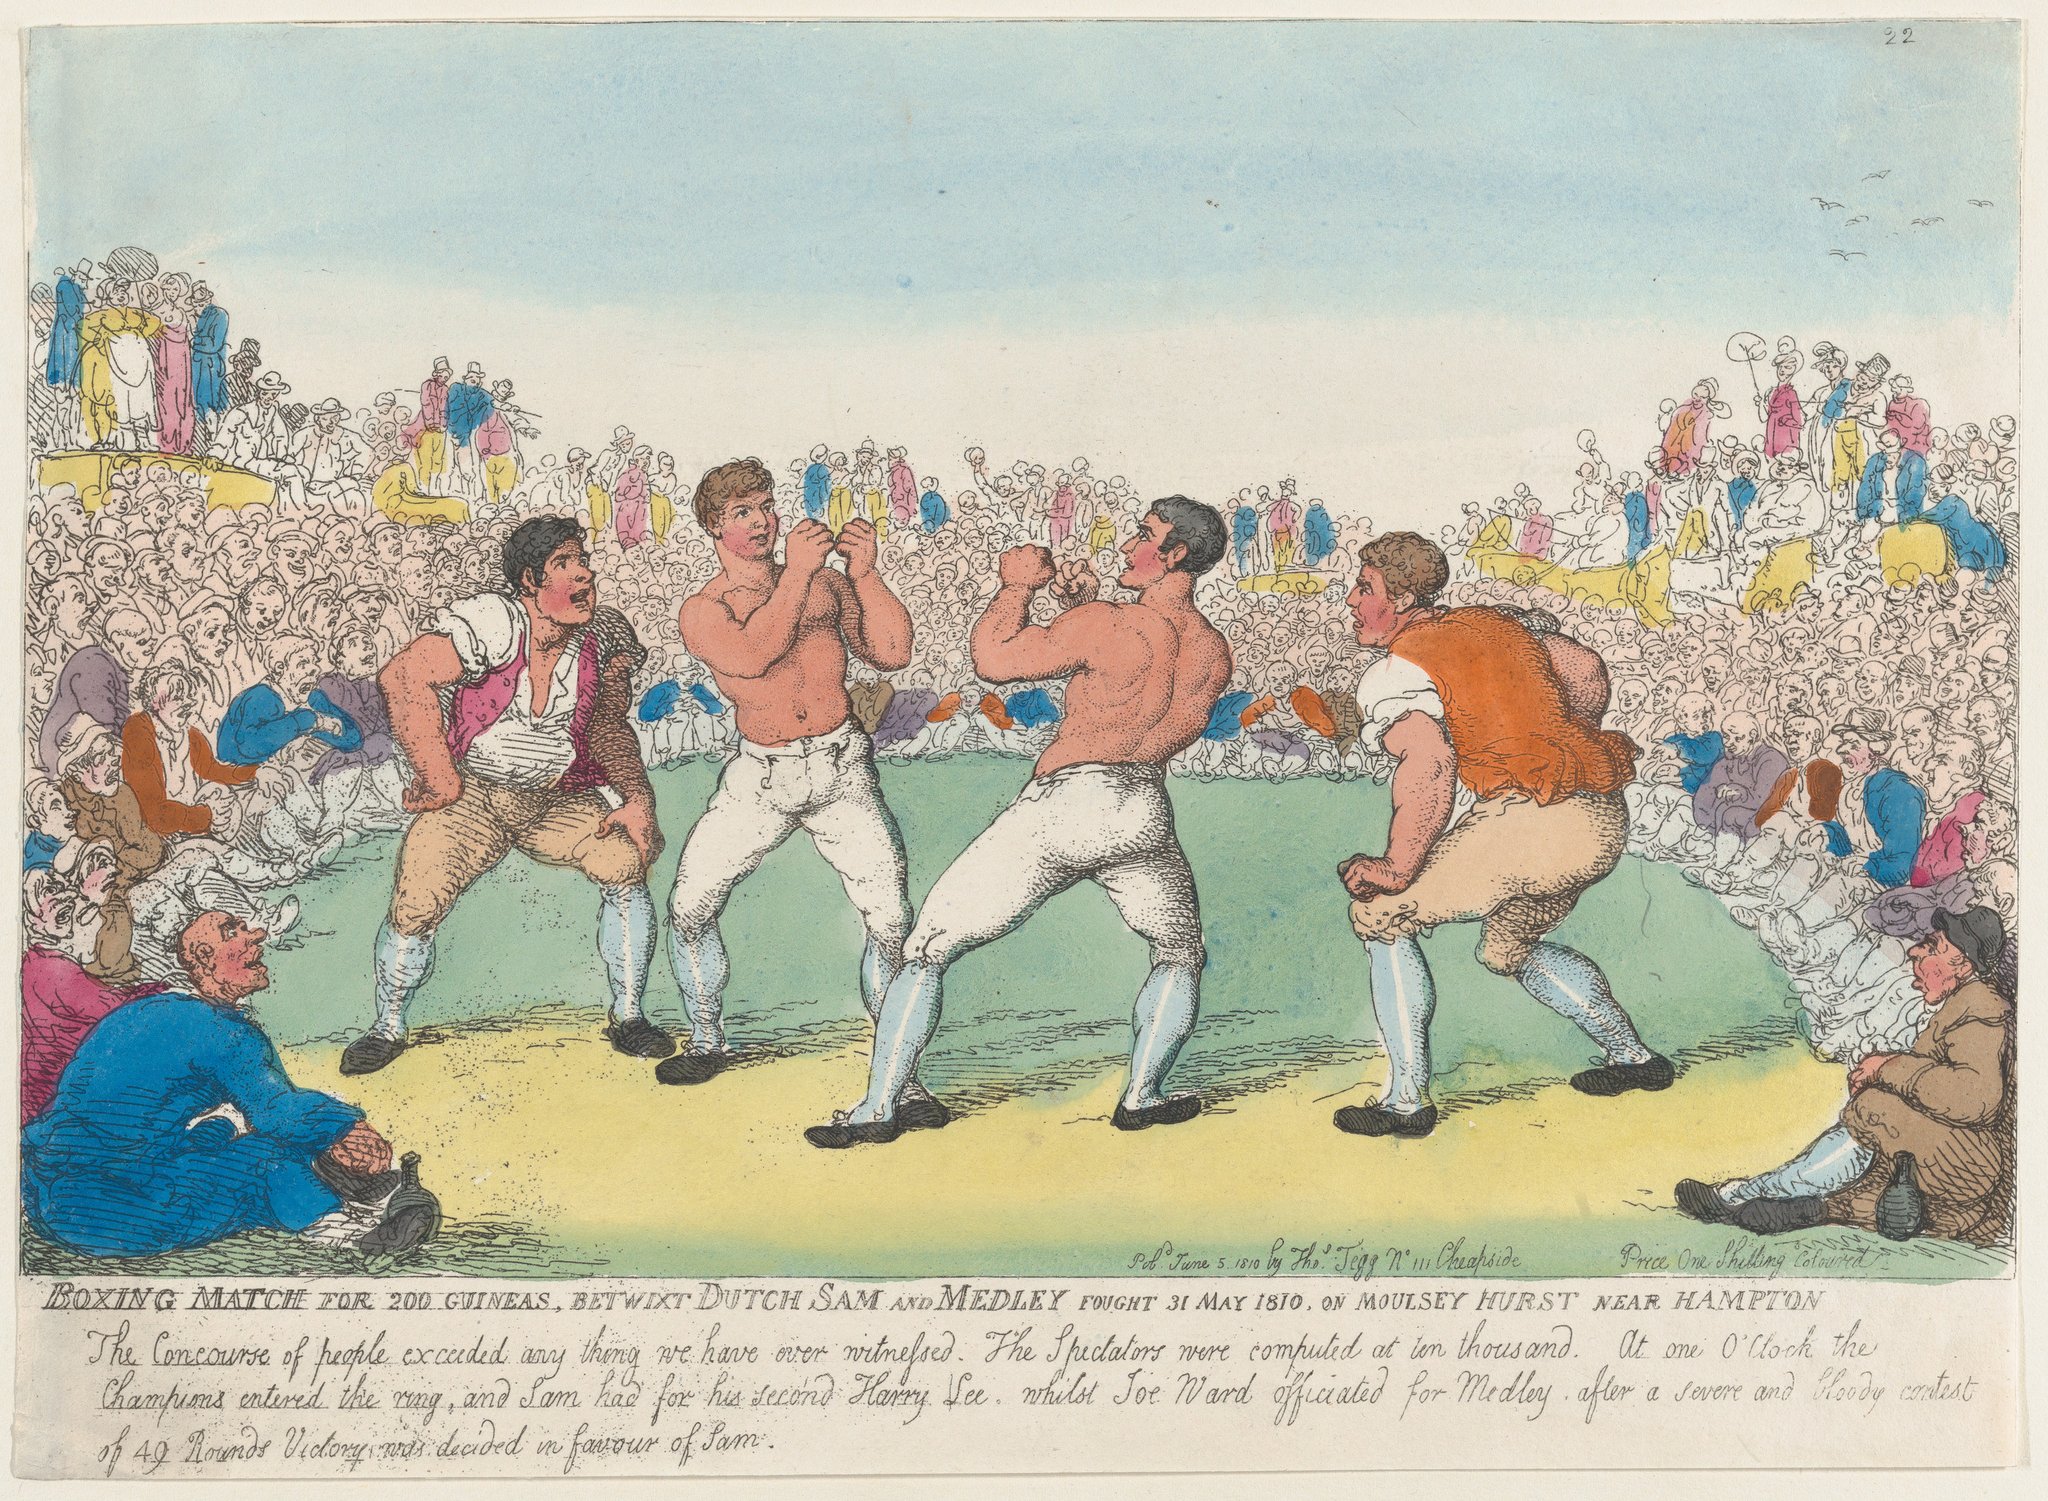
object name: print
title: Boxing Match for 200 Guineas, Betwixt Dutch Sam and Medley, Fought 31 May 1810, on Moulsey Hurst Near Hampton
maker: thomas rowlandson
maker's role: artist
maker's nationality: british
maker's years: 1757-1827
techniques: etching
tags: men,spectators,boxing,athletes